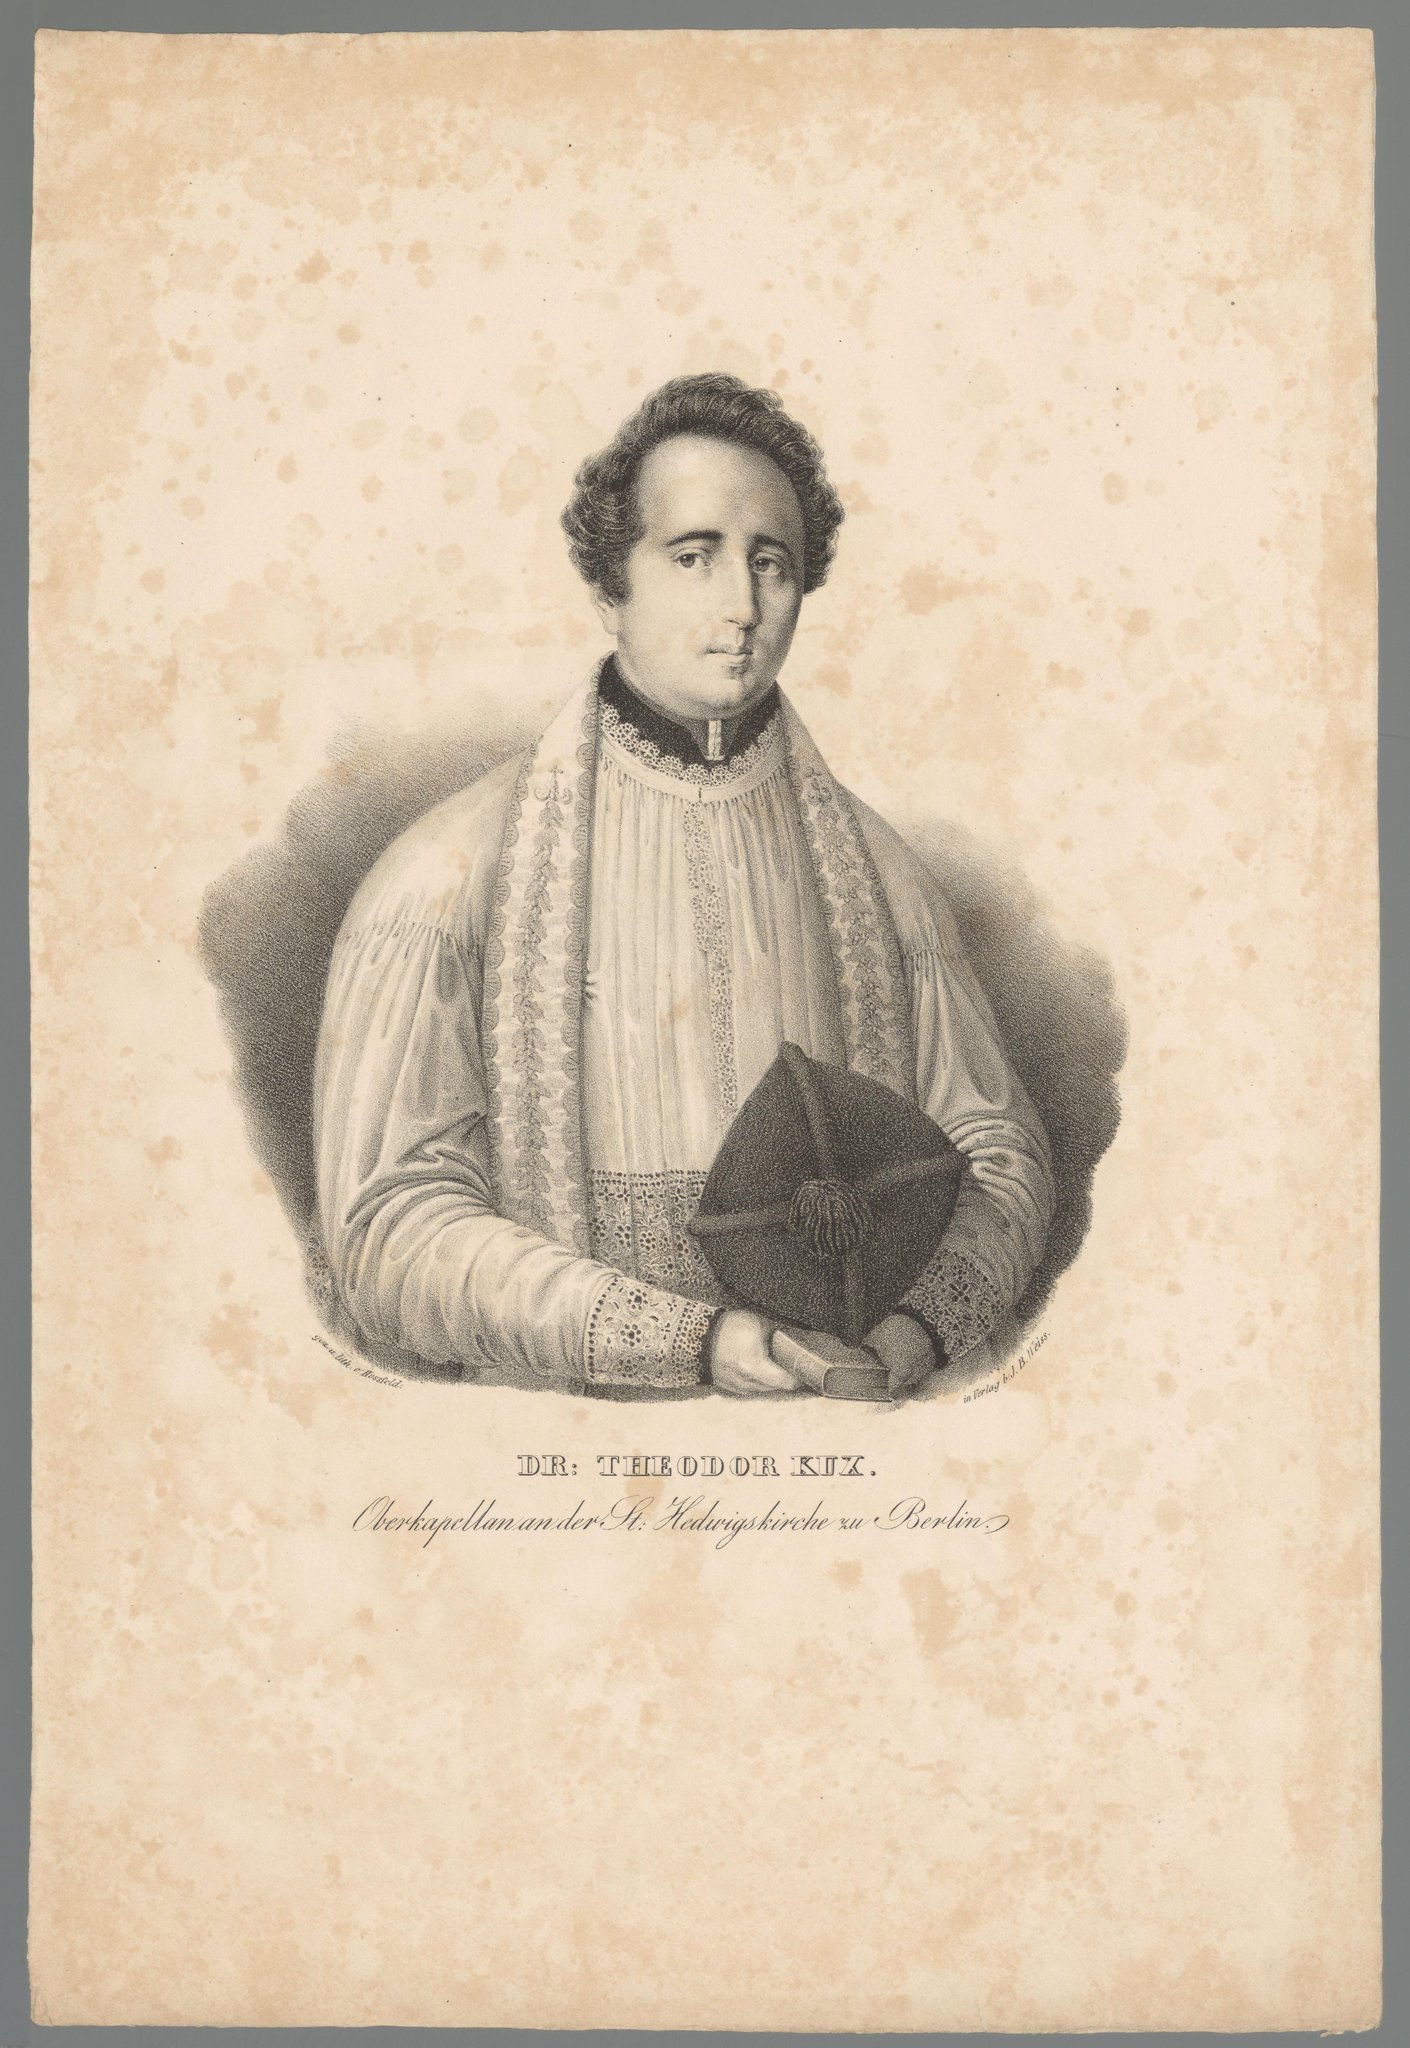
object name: print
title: Dr. Theodor Kux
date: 1830-1875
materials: paper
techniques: lithograph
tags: clergyman, adult man, historical persons, book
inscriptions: collector's mark: Lugt 2228